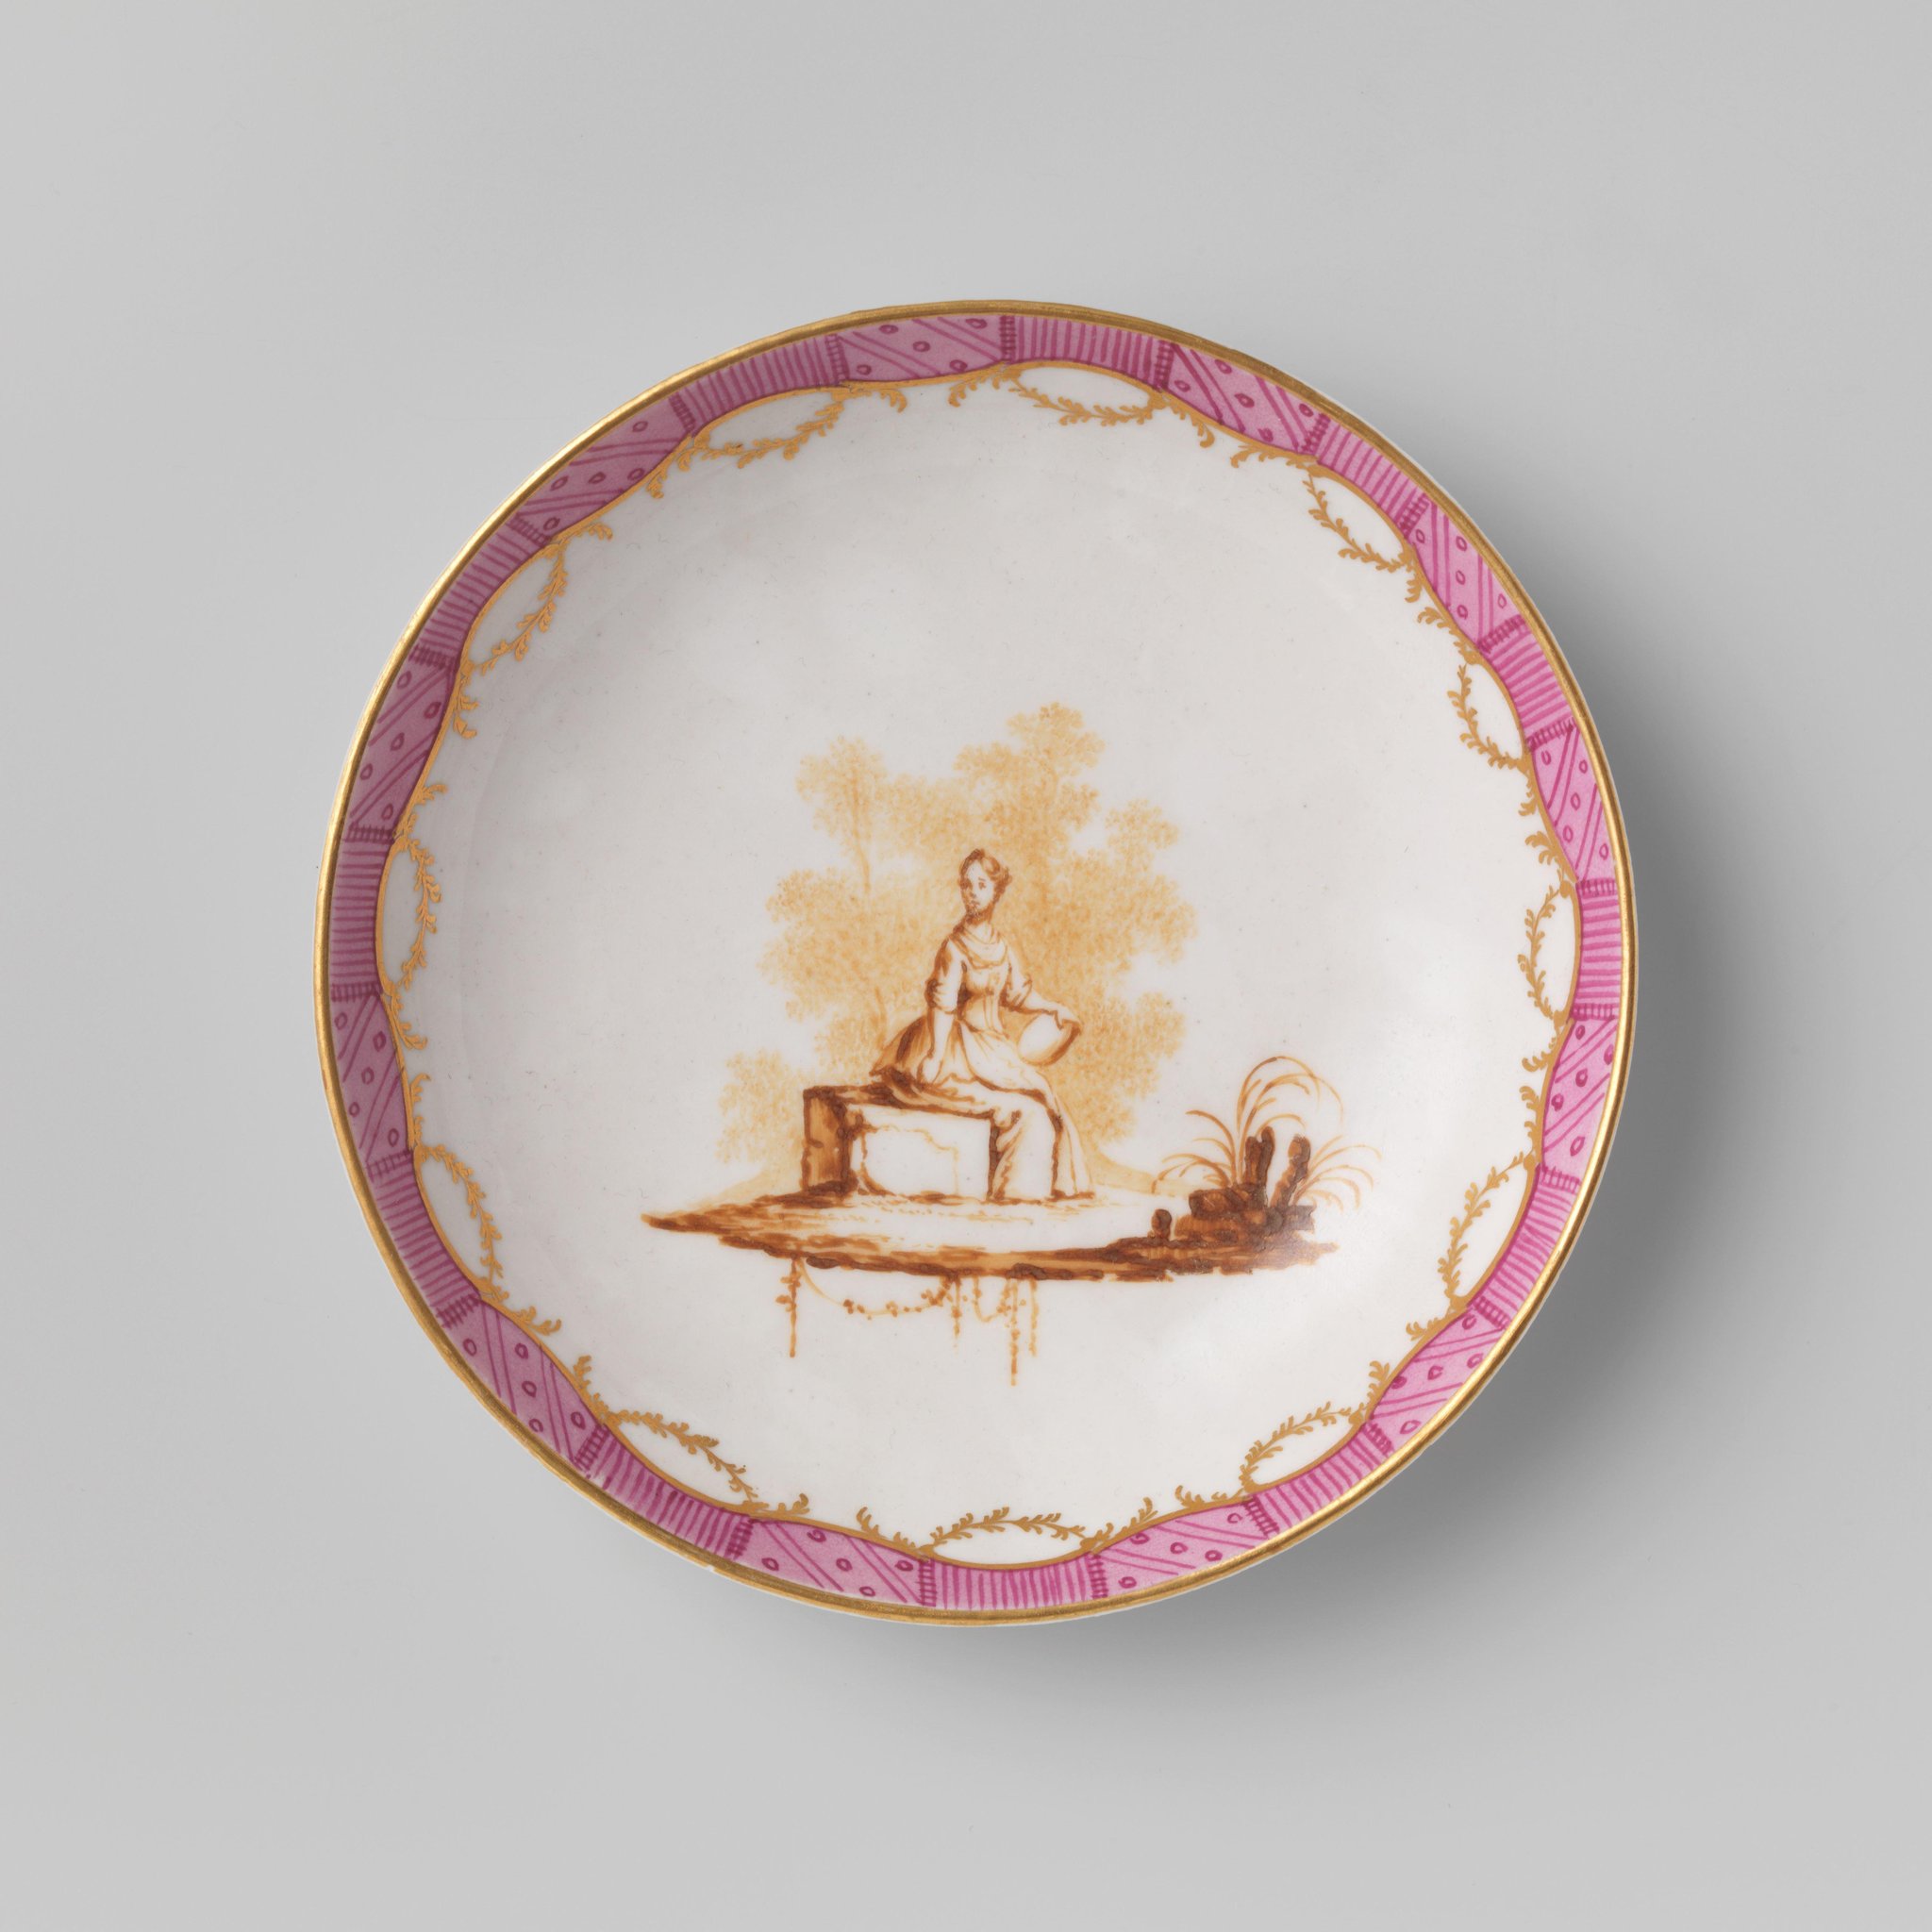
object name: platter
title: Schotel van porselein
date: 1774-1778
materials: porcelain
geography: loosdrecht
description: Schotel van porselein. Beschilderd in sepia met figuren in een landschap. Langs de rand een lila fries tussen gouden biezen.